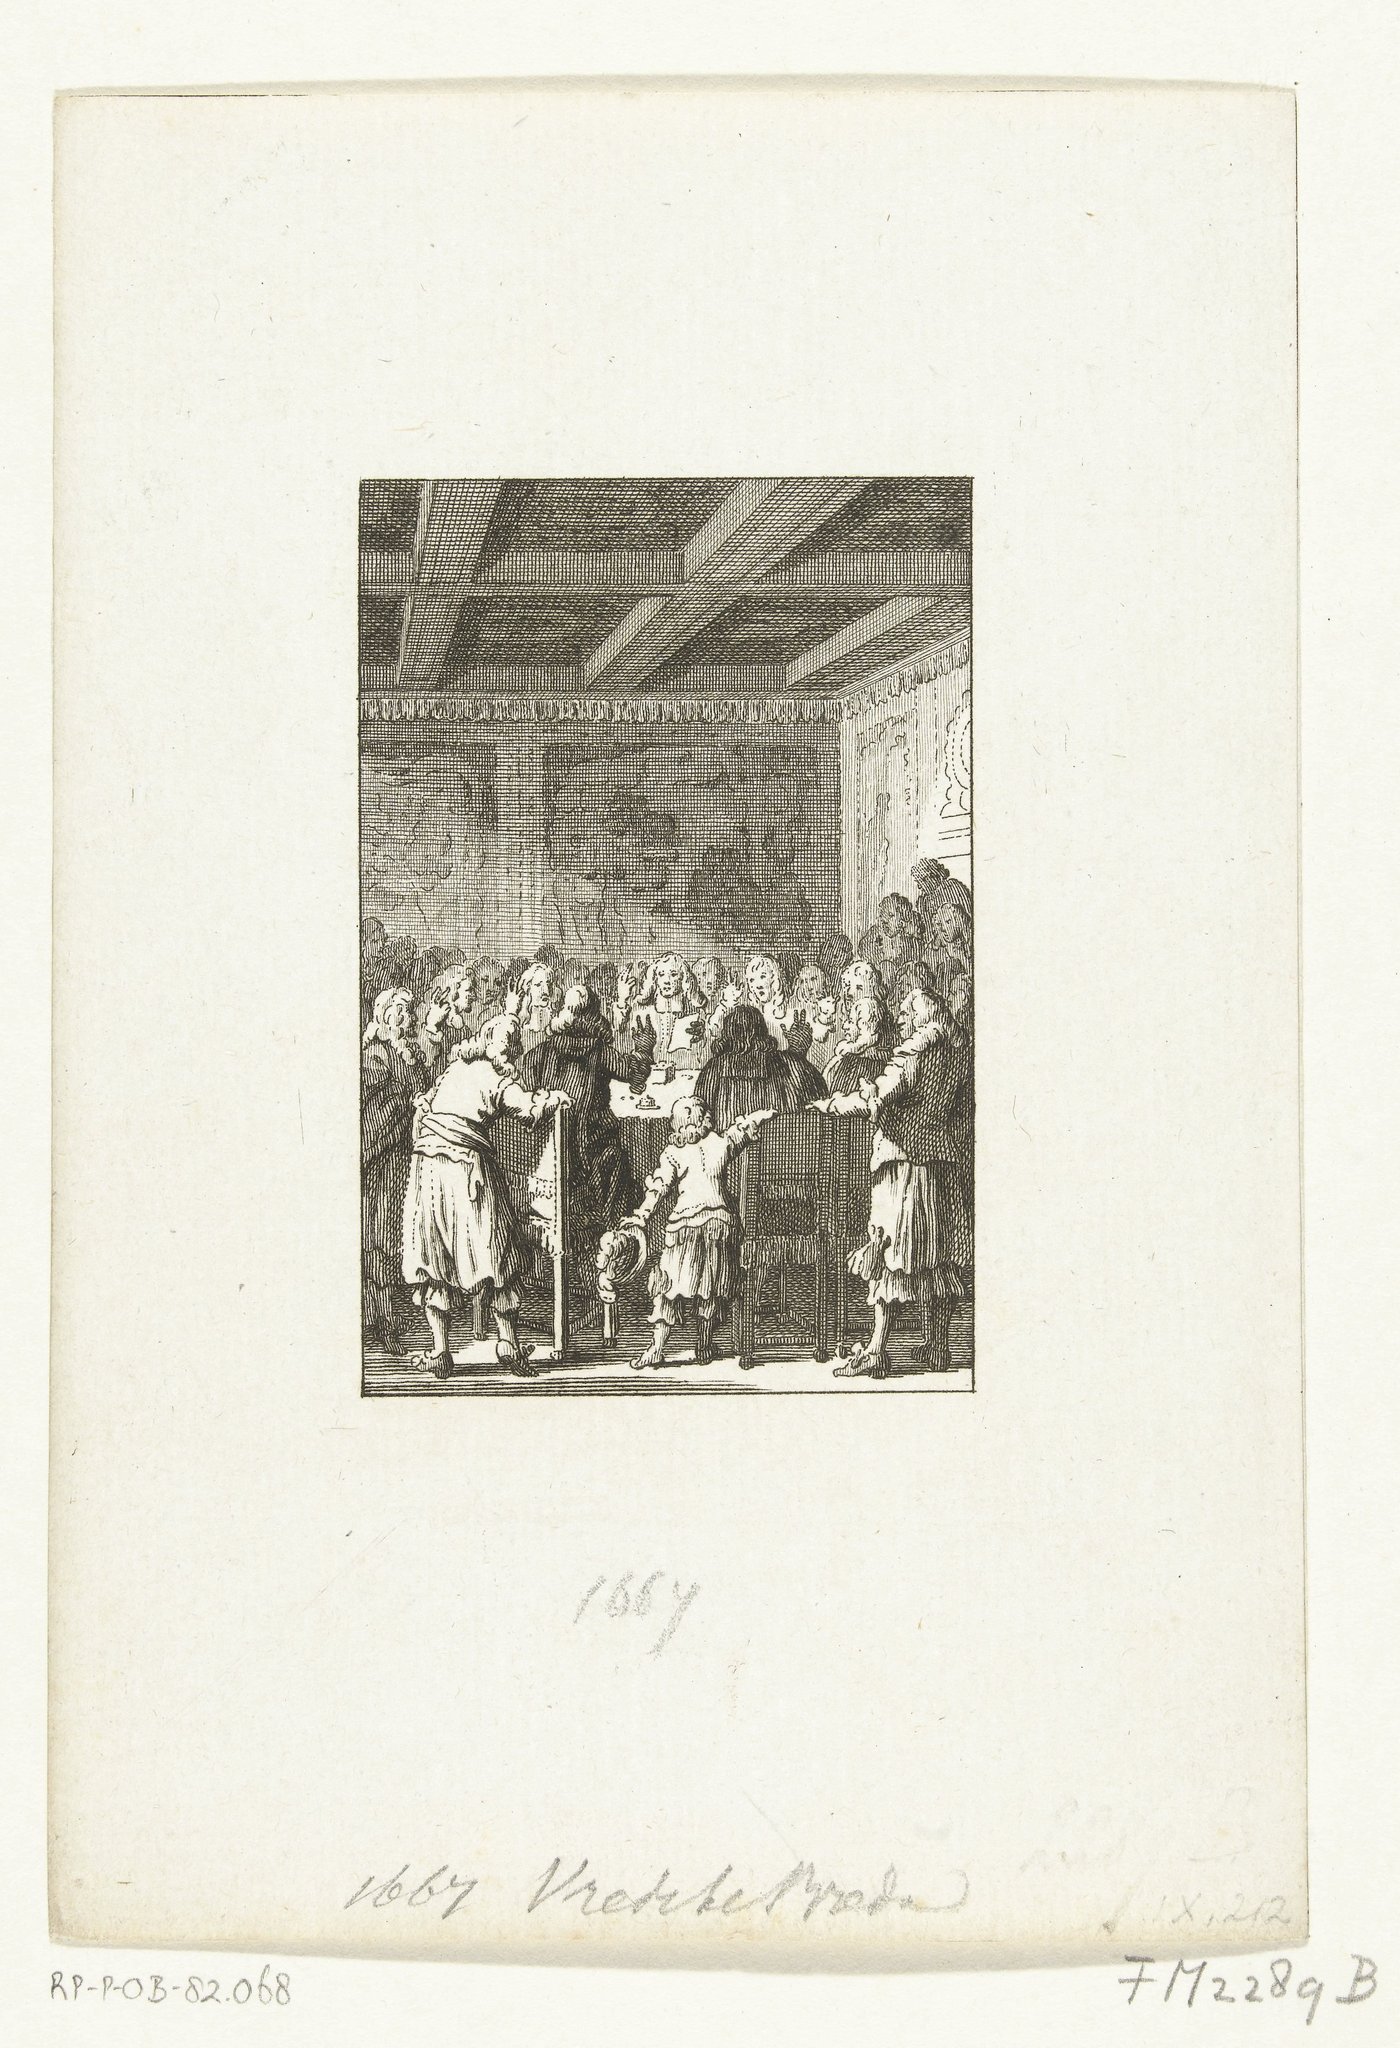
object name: history print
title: Vrede van Breda, 1667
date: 1783-1795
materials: paper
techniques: etching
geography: netherlands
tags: signing of peace treaty, concluding the peace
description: Gebruikt als illustratie in: J. Fokke, Geschiedenissen der Vereenigde Nederlanden voor de vaderlandsche jeugd, Johannes Allart, Amsterdam 1783-1795, 25 delen, dl. IX, pl. X. Dit nummer is een door het RPK toegevoegd nummer en staat niet in Frederik Muller, het werk waar de prent voor is gemaakt of uit afkomstig is, staat wel vermeld in Frederik Muller.